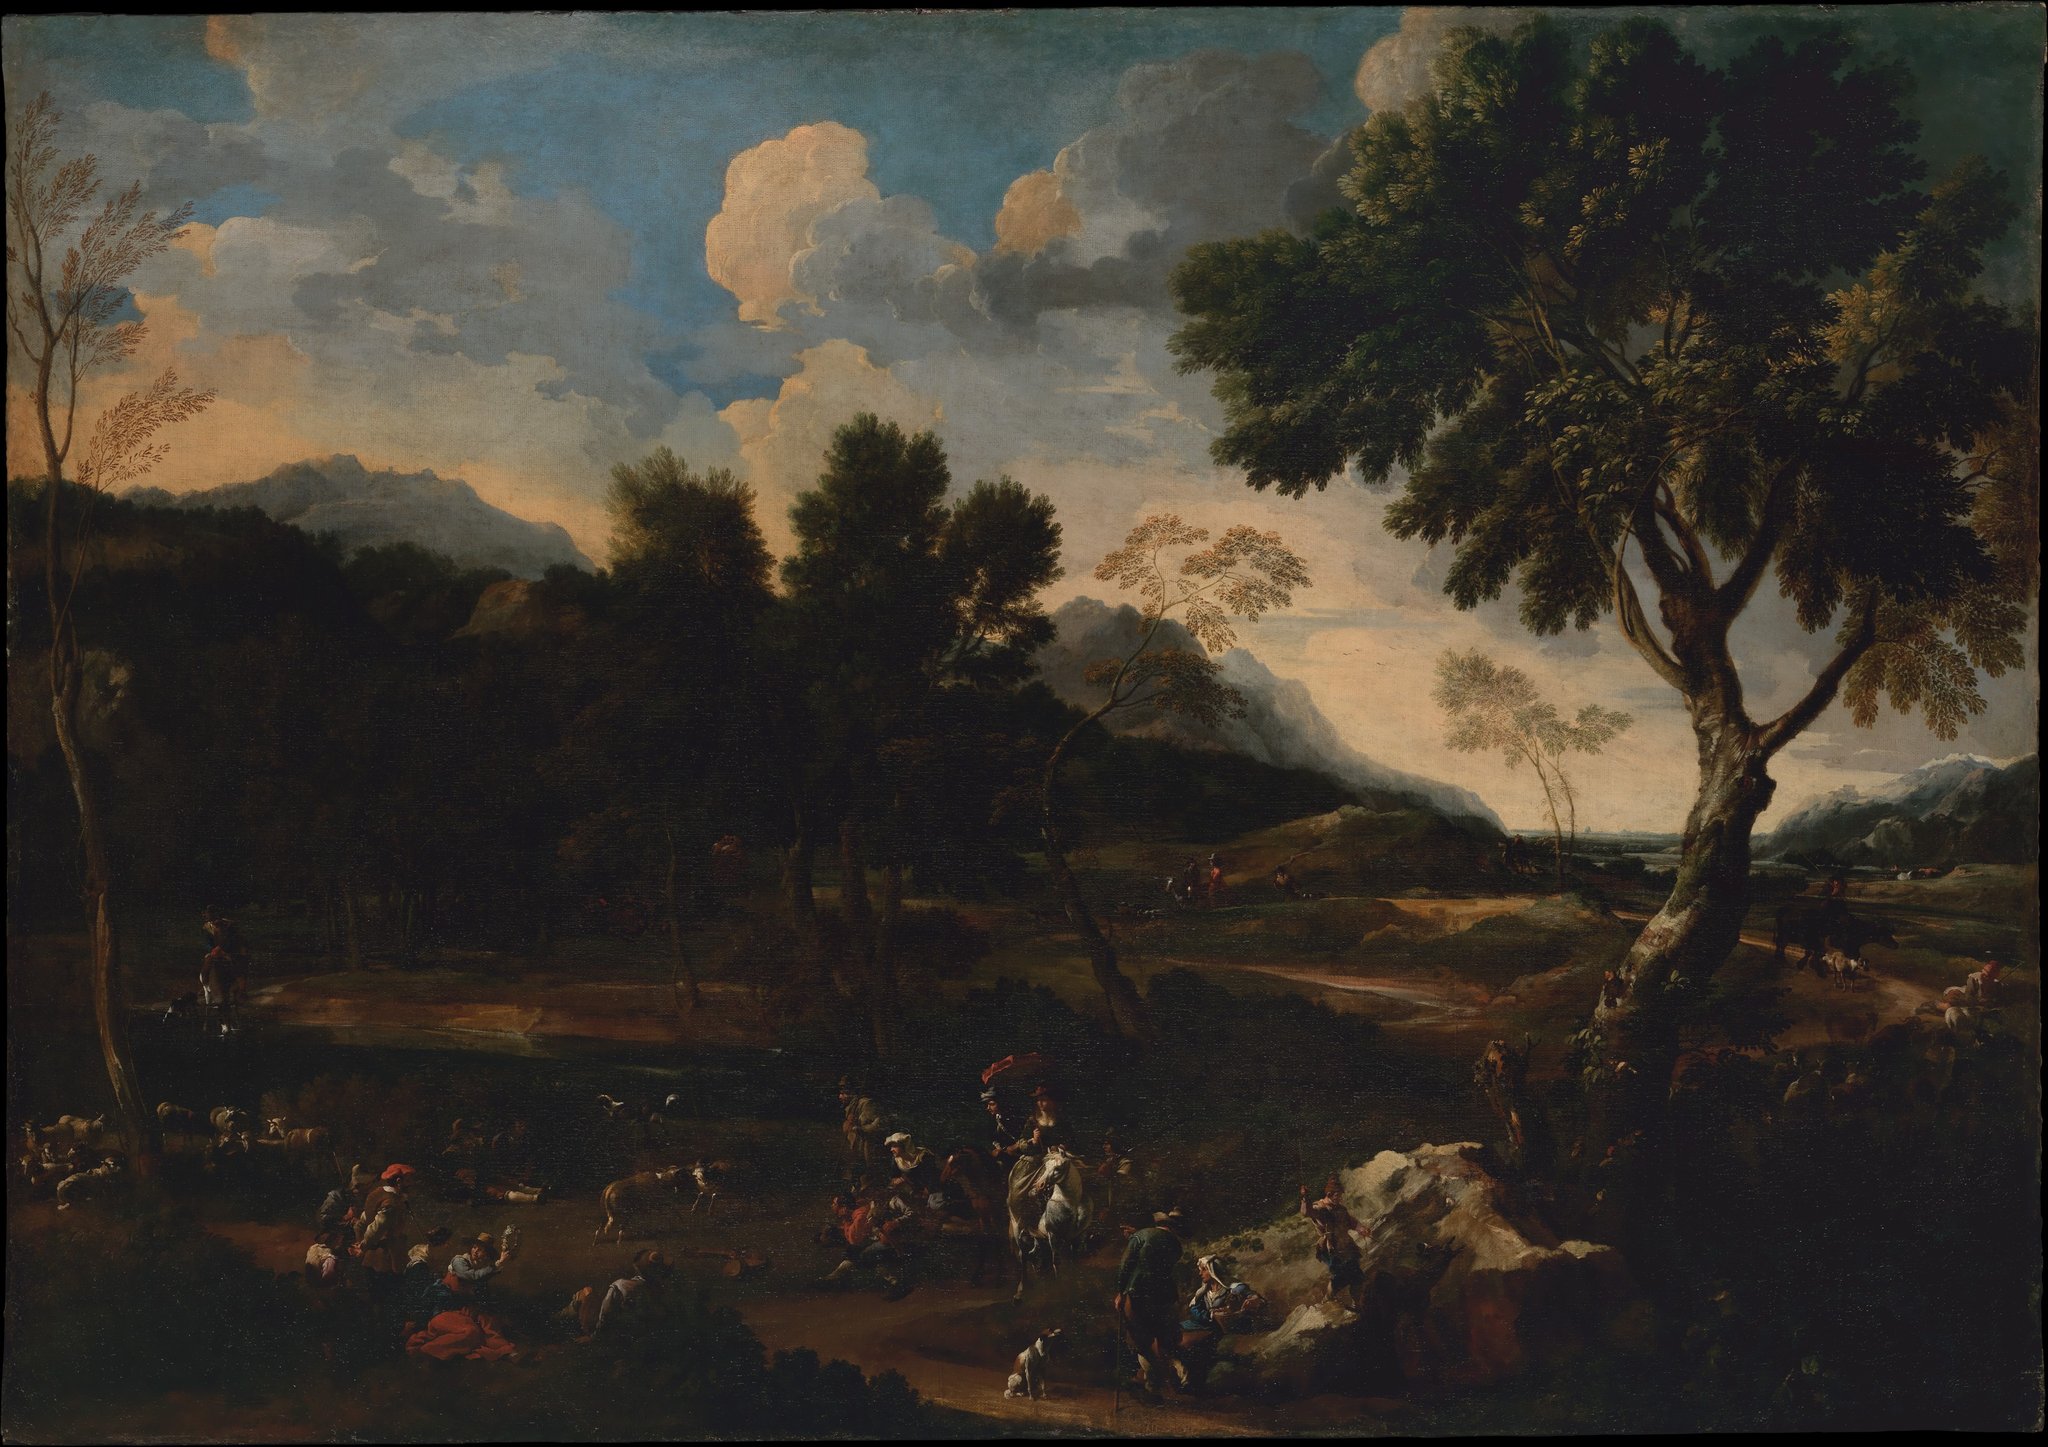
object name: painting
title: Landscape with a Battle between Two Rams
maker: jan miel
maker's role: artist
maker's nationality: flemish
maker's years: 1599-1664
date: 1640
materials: canvas, oil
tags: men,women,horses,rams,landscapes